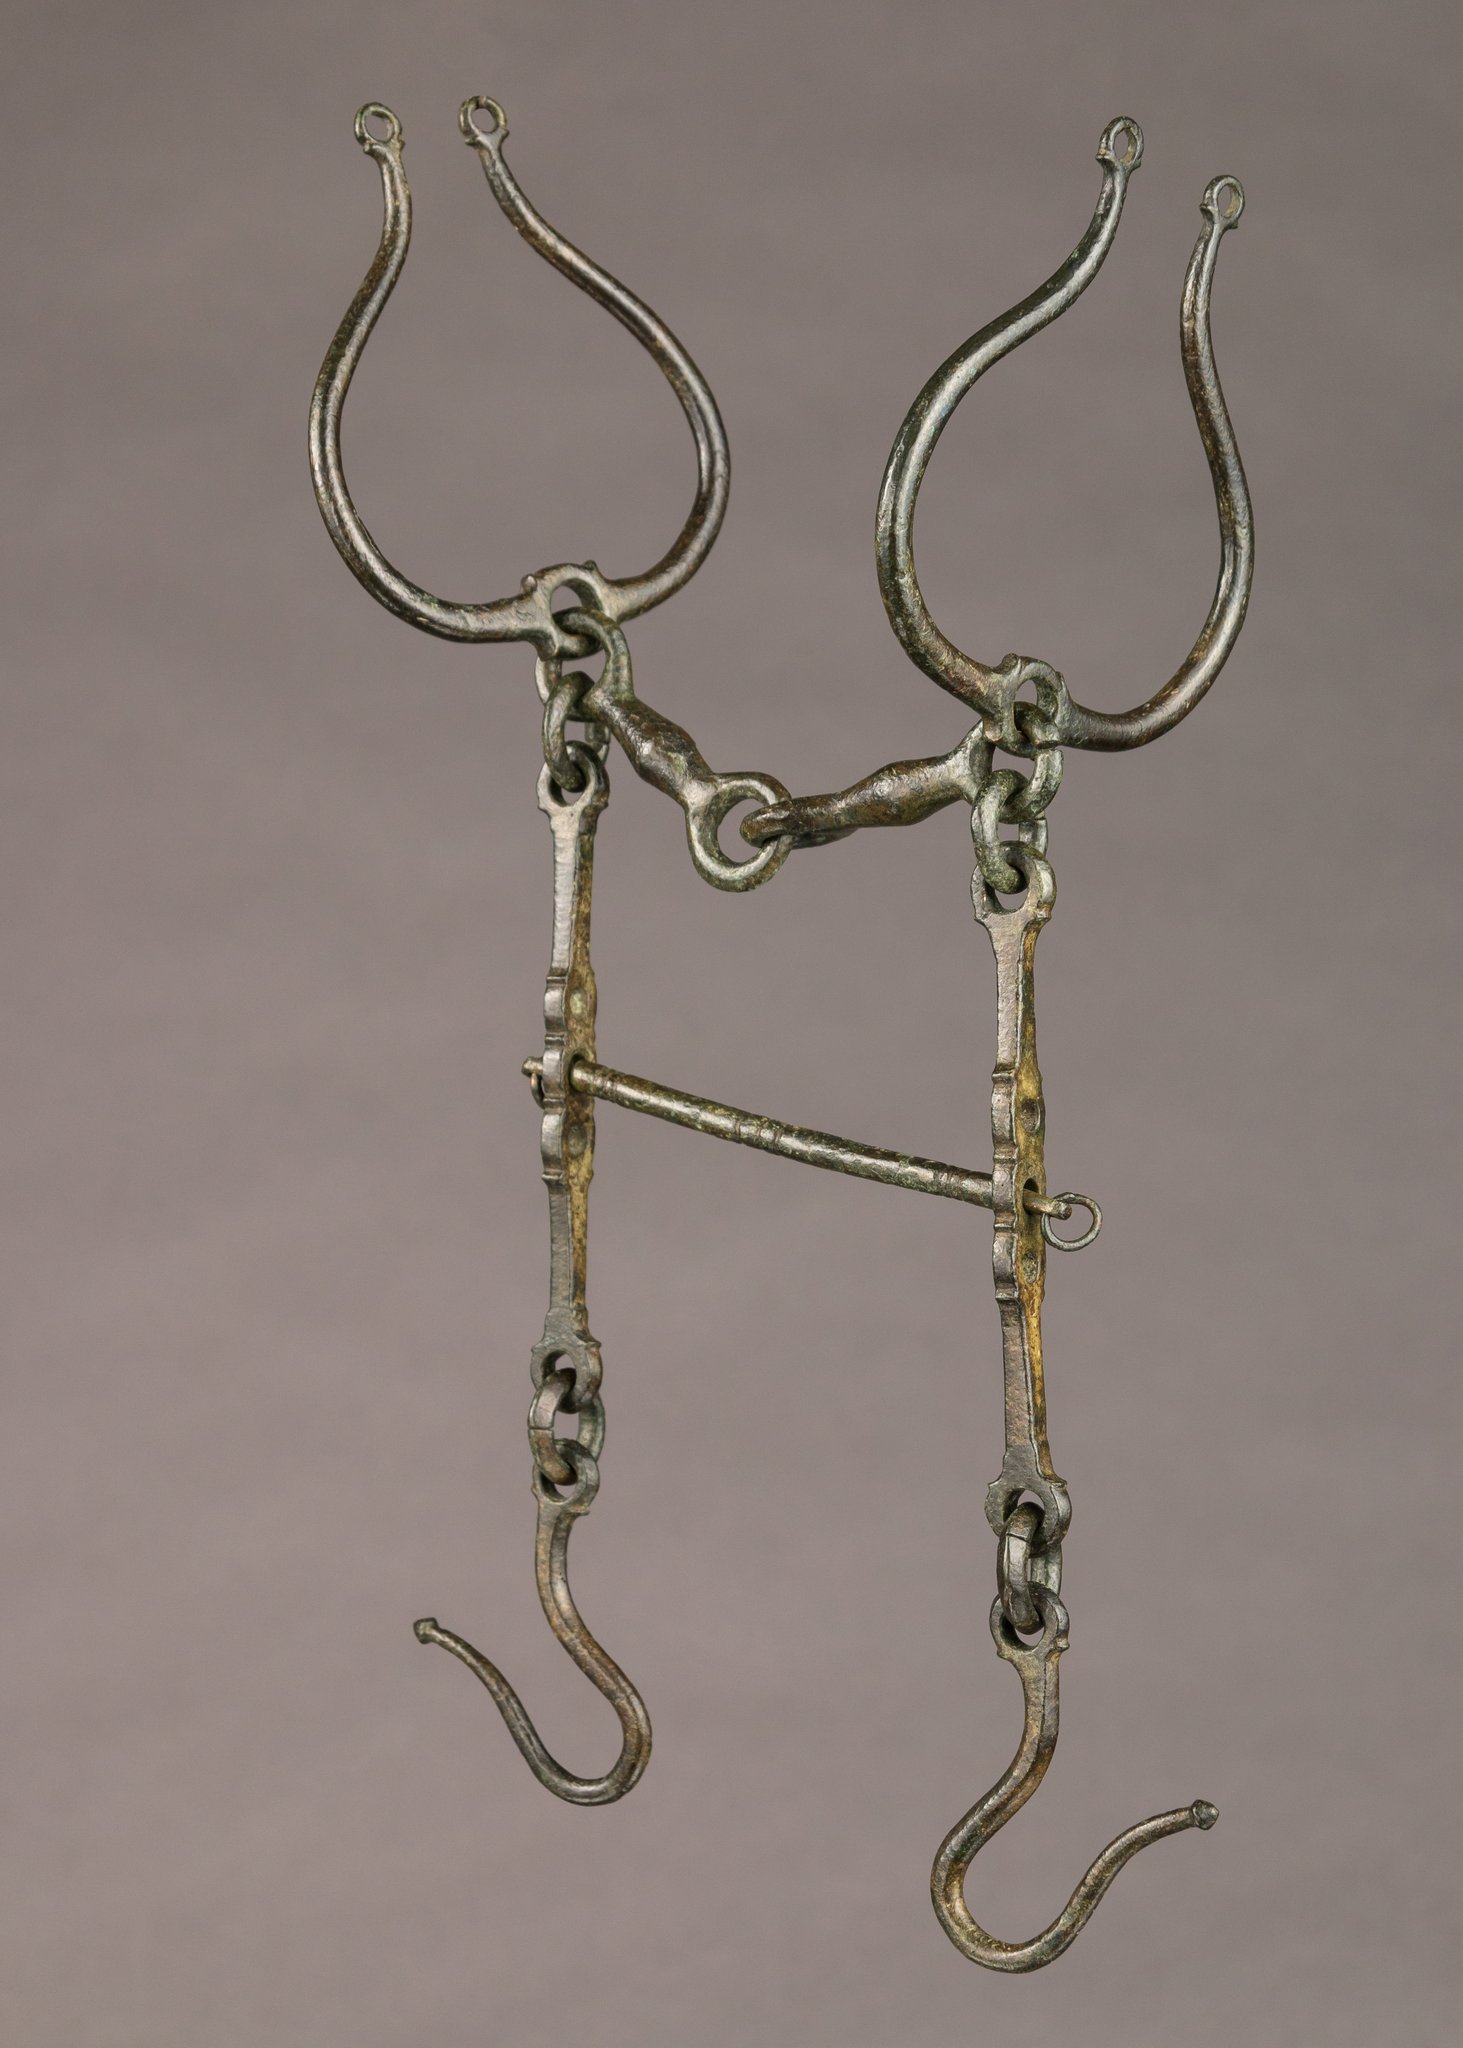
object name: bit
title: Curb Bit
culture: celtic or thracian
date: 200-1 BCE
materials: copper alloy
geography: italy